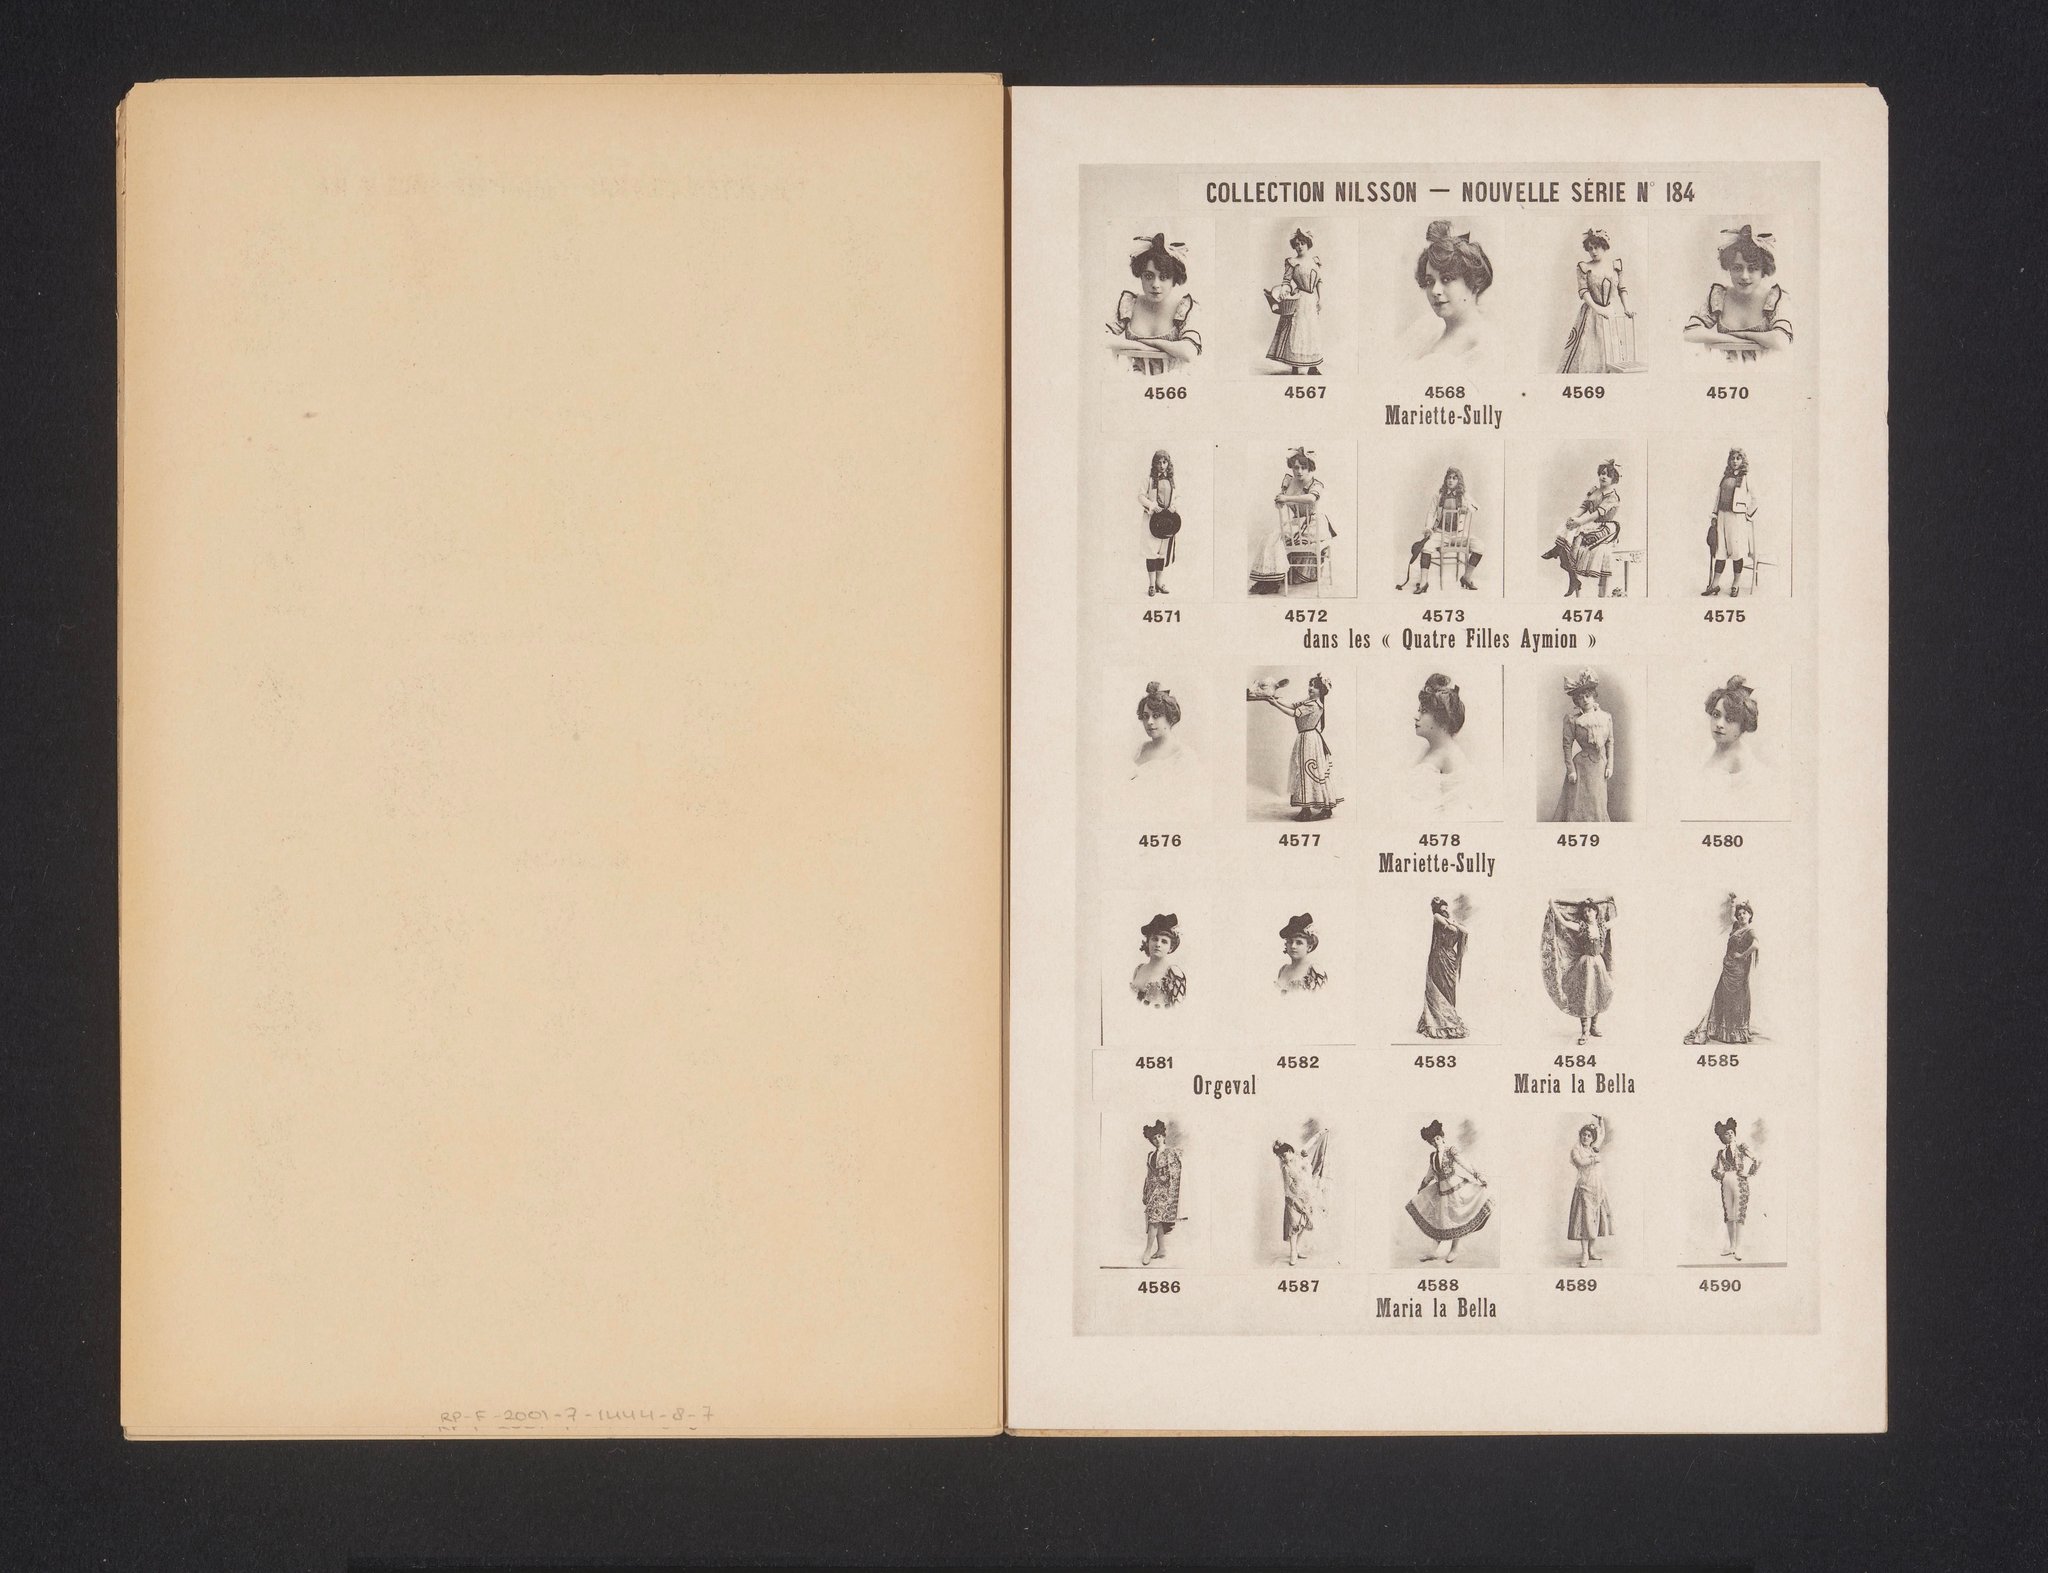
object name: page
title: Collection Nilsson - Nouvelle Série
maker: Anonymous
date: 1894-1899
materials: paper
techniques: photograph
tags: portrait of artiste (dancer, actor, etc.), historical persons - bb - woman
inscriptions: number: ‘No 184’, inscription: ‘Mariette-Sully/ dans les < < Quatre Filles Aymion > >/ Mariette-Sully/ Orgeval Maria la Bella/ Maria la Bella’